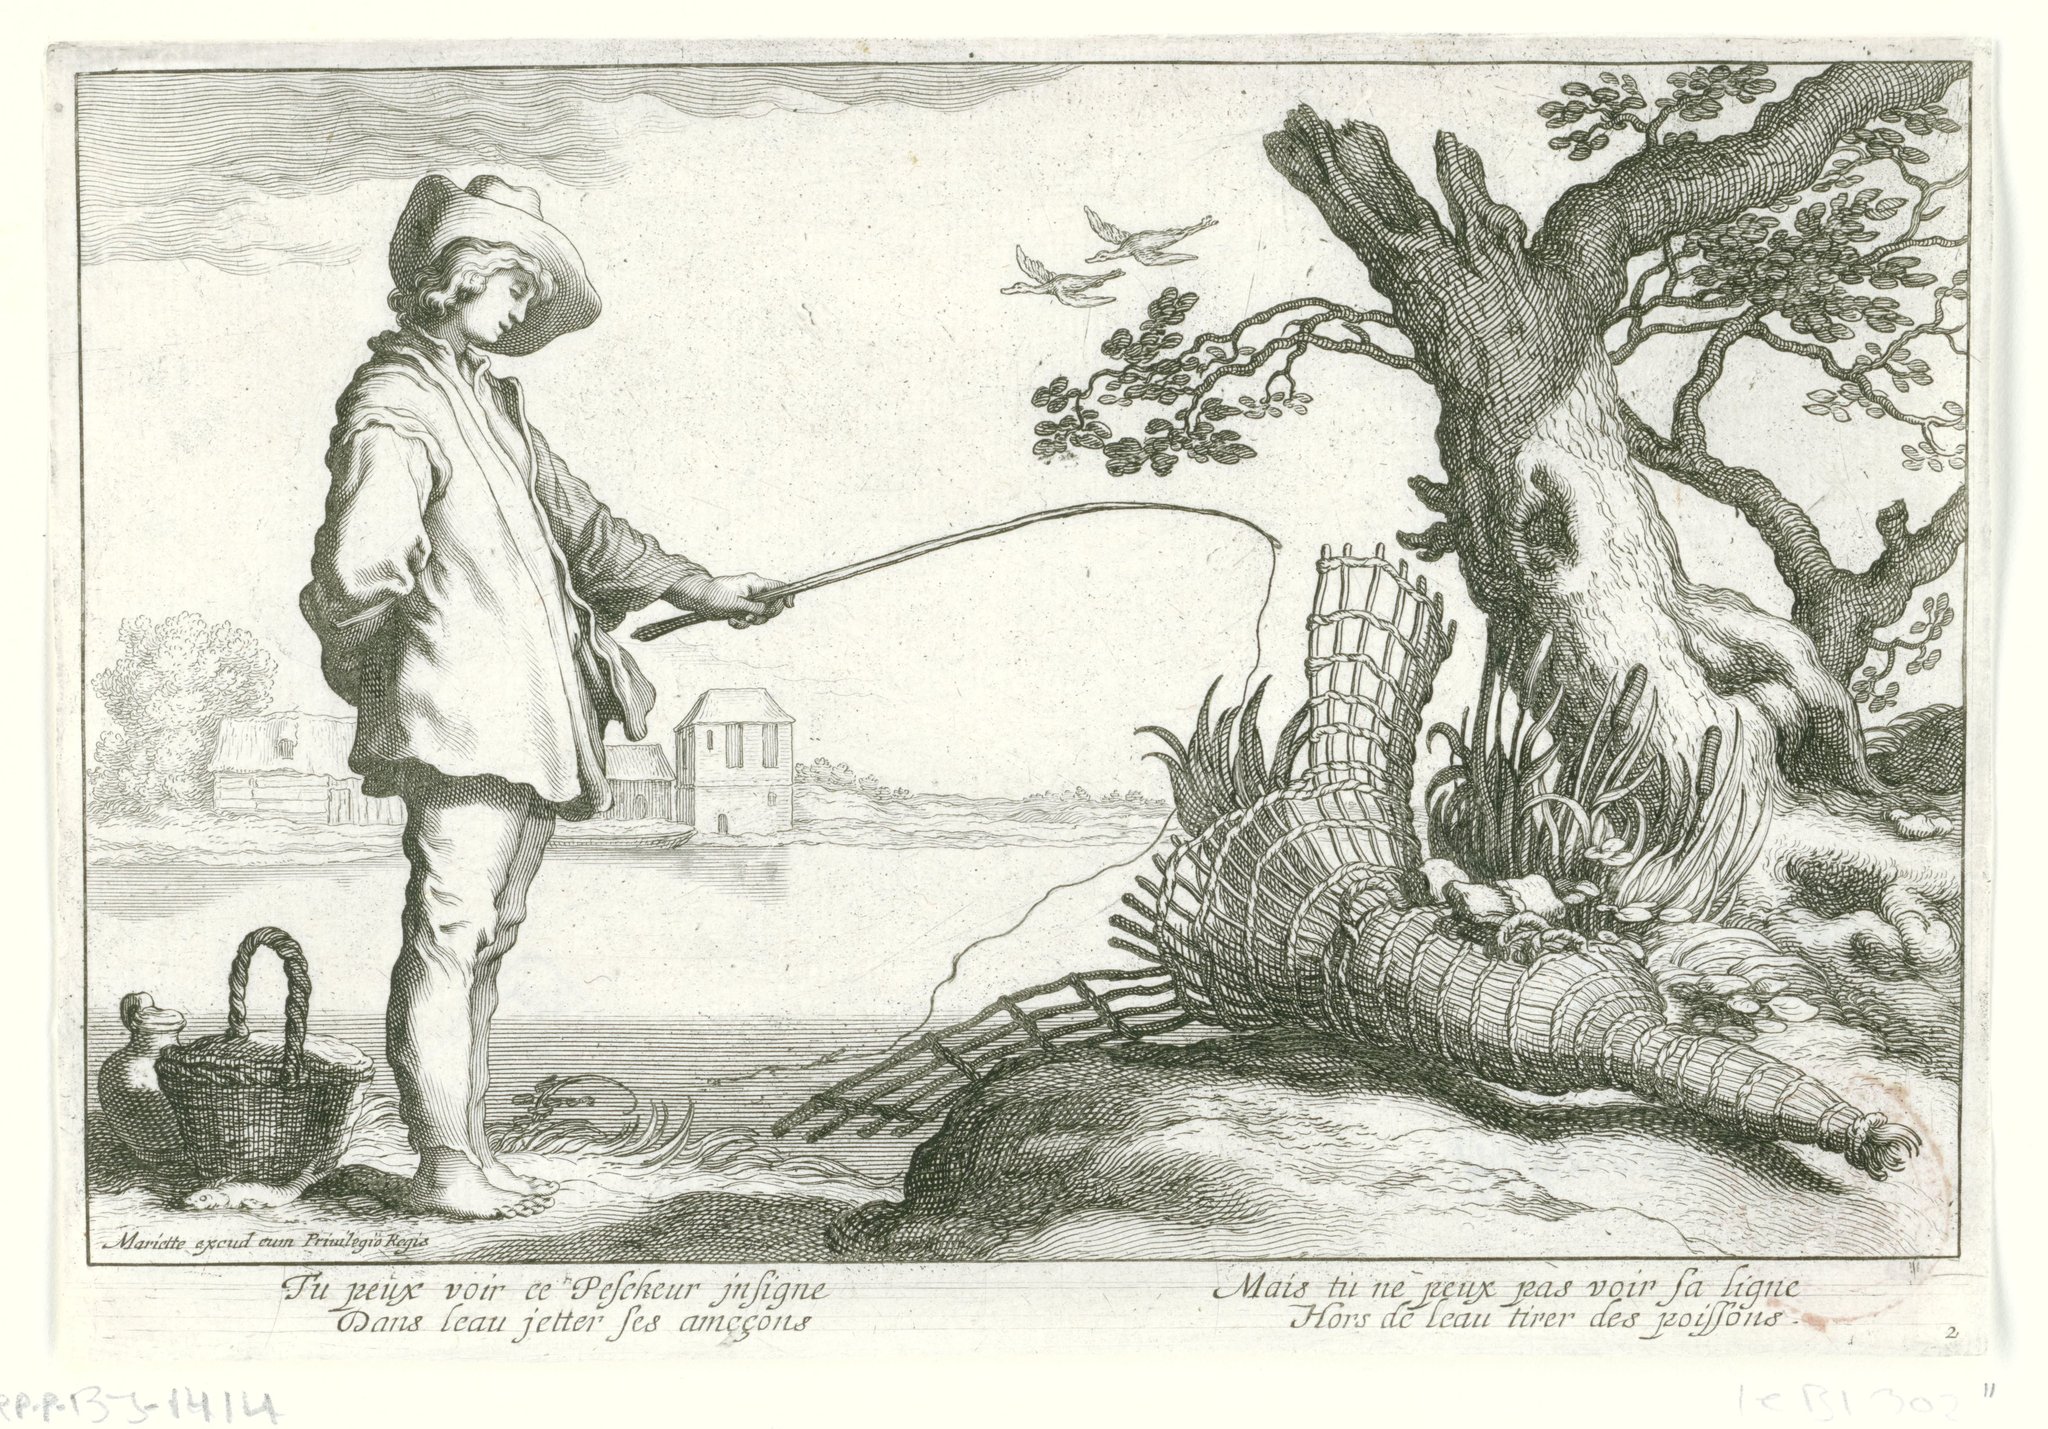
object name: print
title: De jonge visser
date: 1650-1716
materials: paper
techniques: engraving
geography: paris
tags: angling, pastorals, arcadian scenes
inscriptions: collector's mark: Lugt 240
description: Een jonge man staat naast een mand en kruik aan de rand van een meer en buigt zich iets naar voren over een vislijn. Rechts staat een boom waaronder een fuik ligt. Het vierregelig Franstalig onderschrift meldt dat men wel kan zien dat de visser zijn hengel heeft uitgegooid, maar niet wat hij daarmee opvist. Vissen was een wijdverspreid symbool van amoureuze activiteit, gebaseerd op de notie van het onbetrouwbare lokaas. De fuik stelt hier de valkuil van de liefde voor.